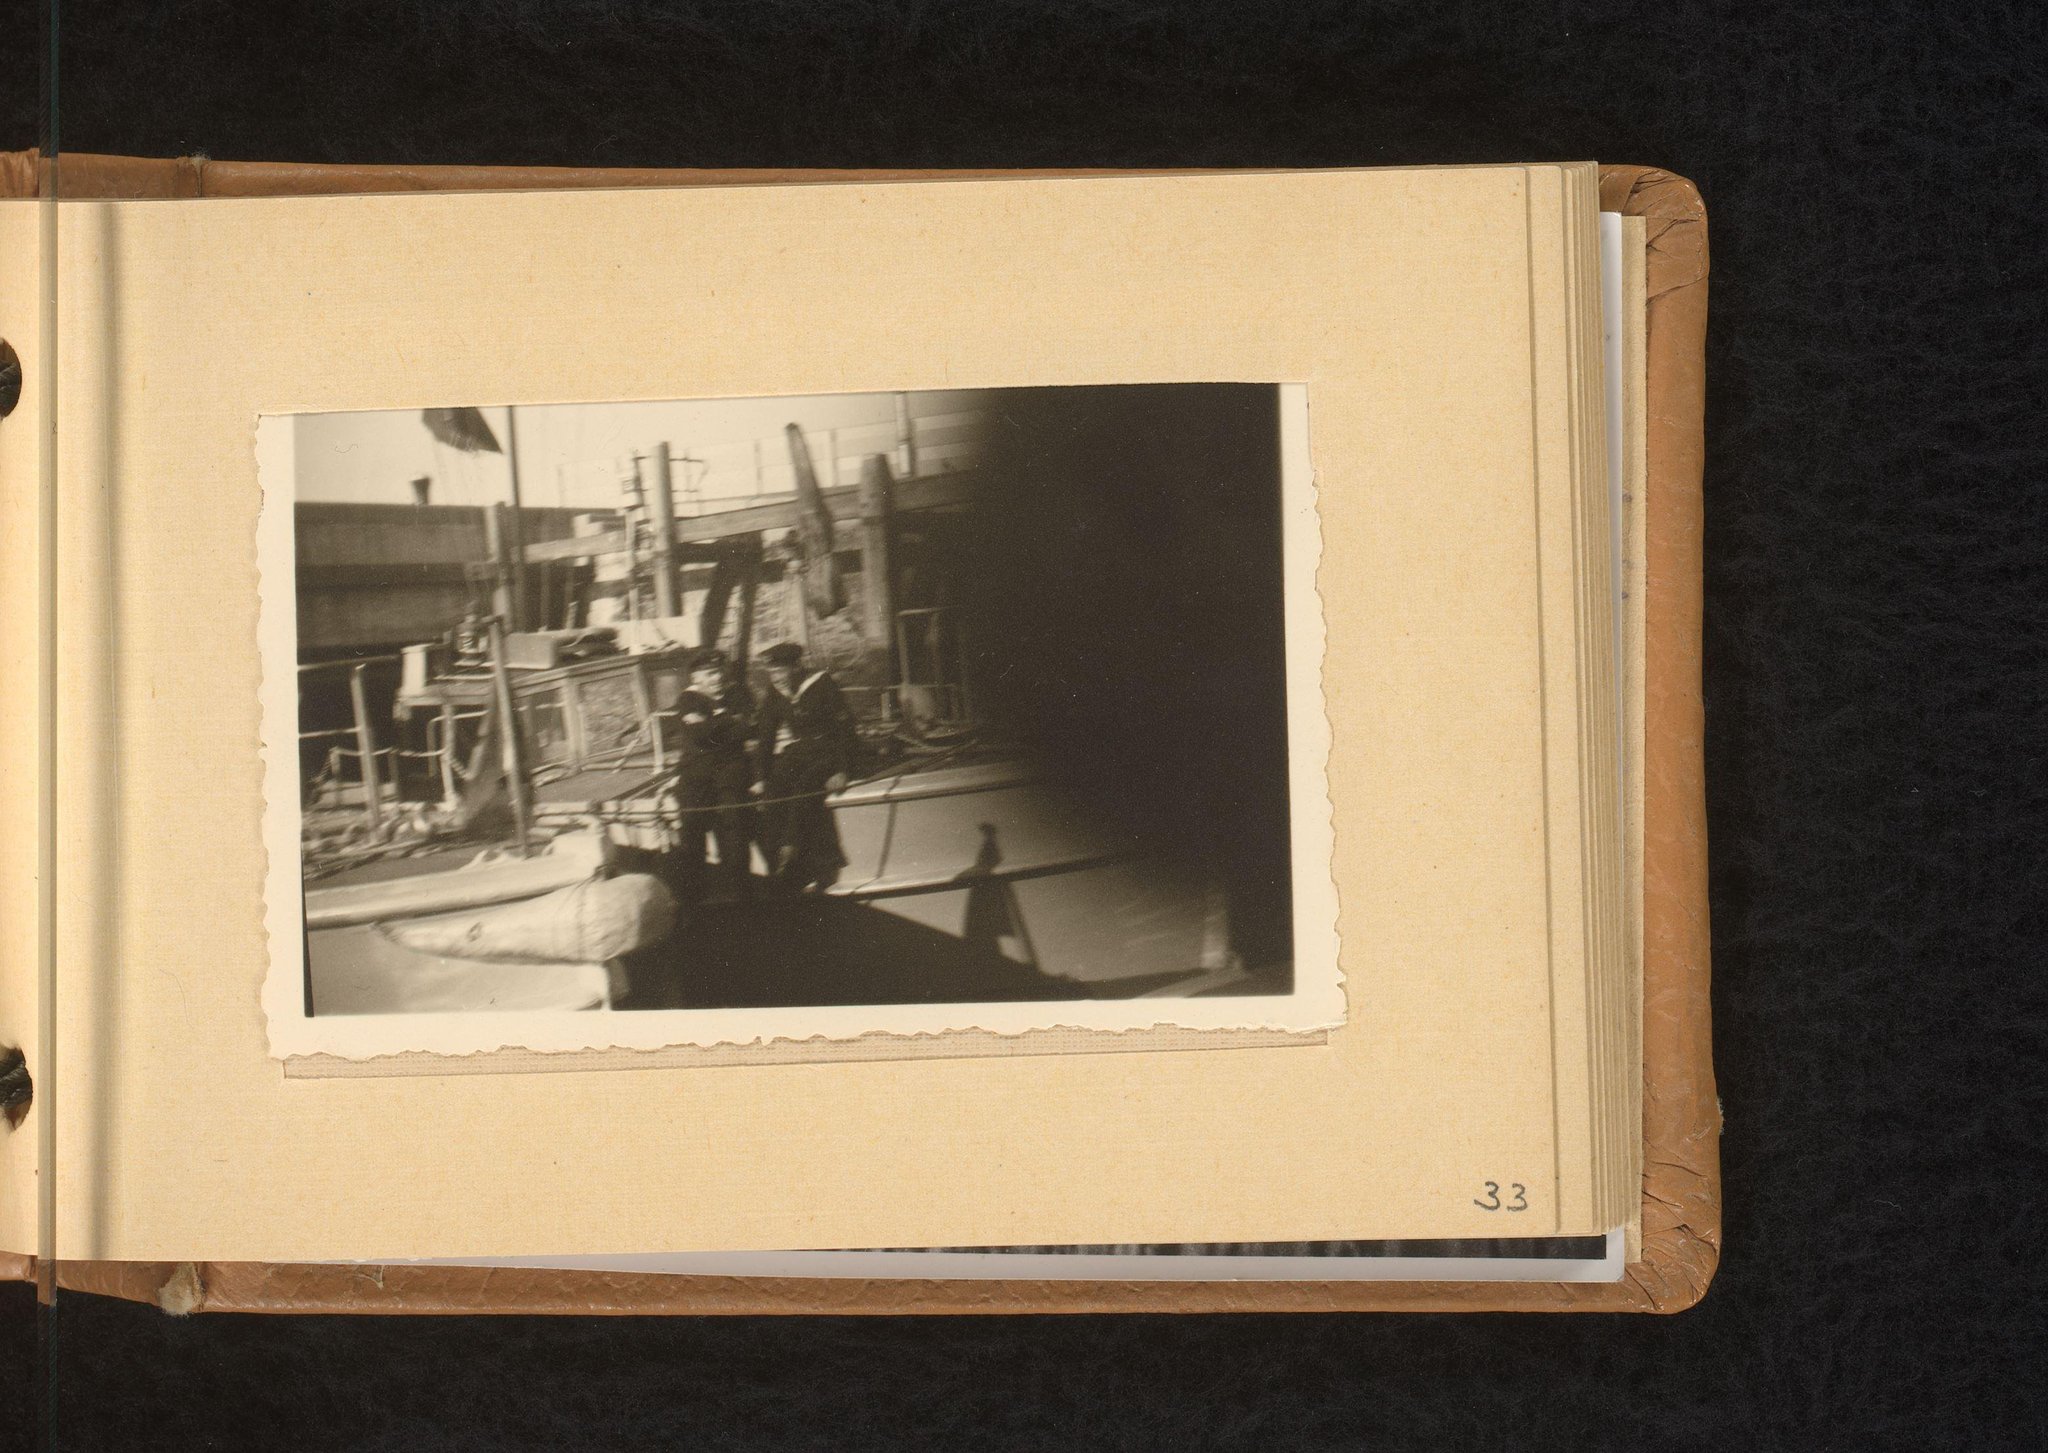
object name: album leaf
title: Schip van de Kriegsmarine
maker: Anonymous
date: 1940-1943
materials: paper, photographic support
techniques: gelatin silver print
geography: netherlands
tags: navy (+ motor ships), occupation ~ war, netherlands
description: Albumblad met een foto van de bemanning op een klein schip van de Kriegsmarine. Onderdeel van een klein album van de Kriegsmarine in Nederland.